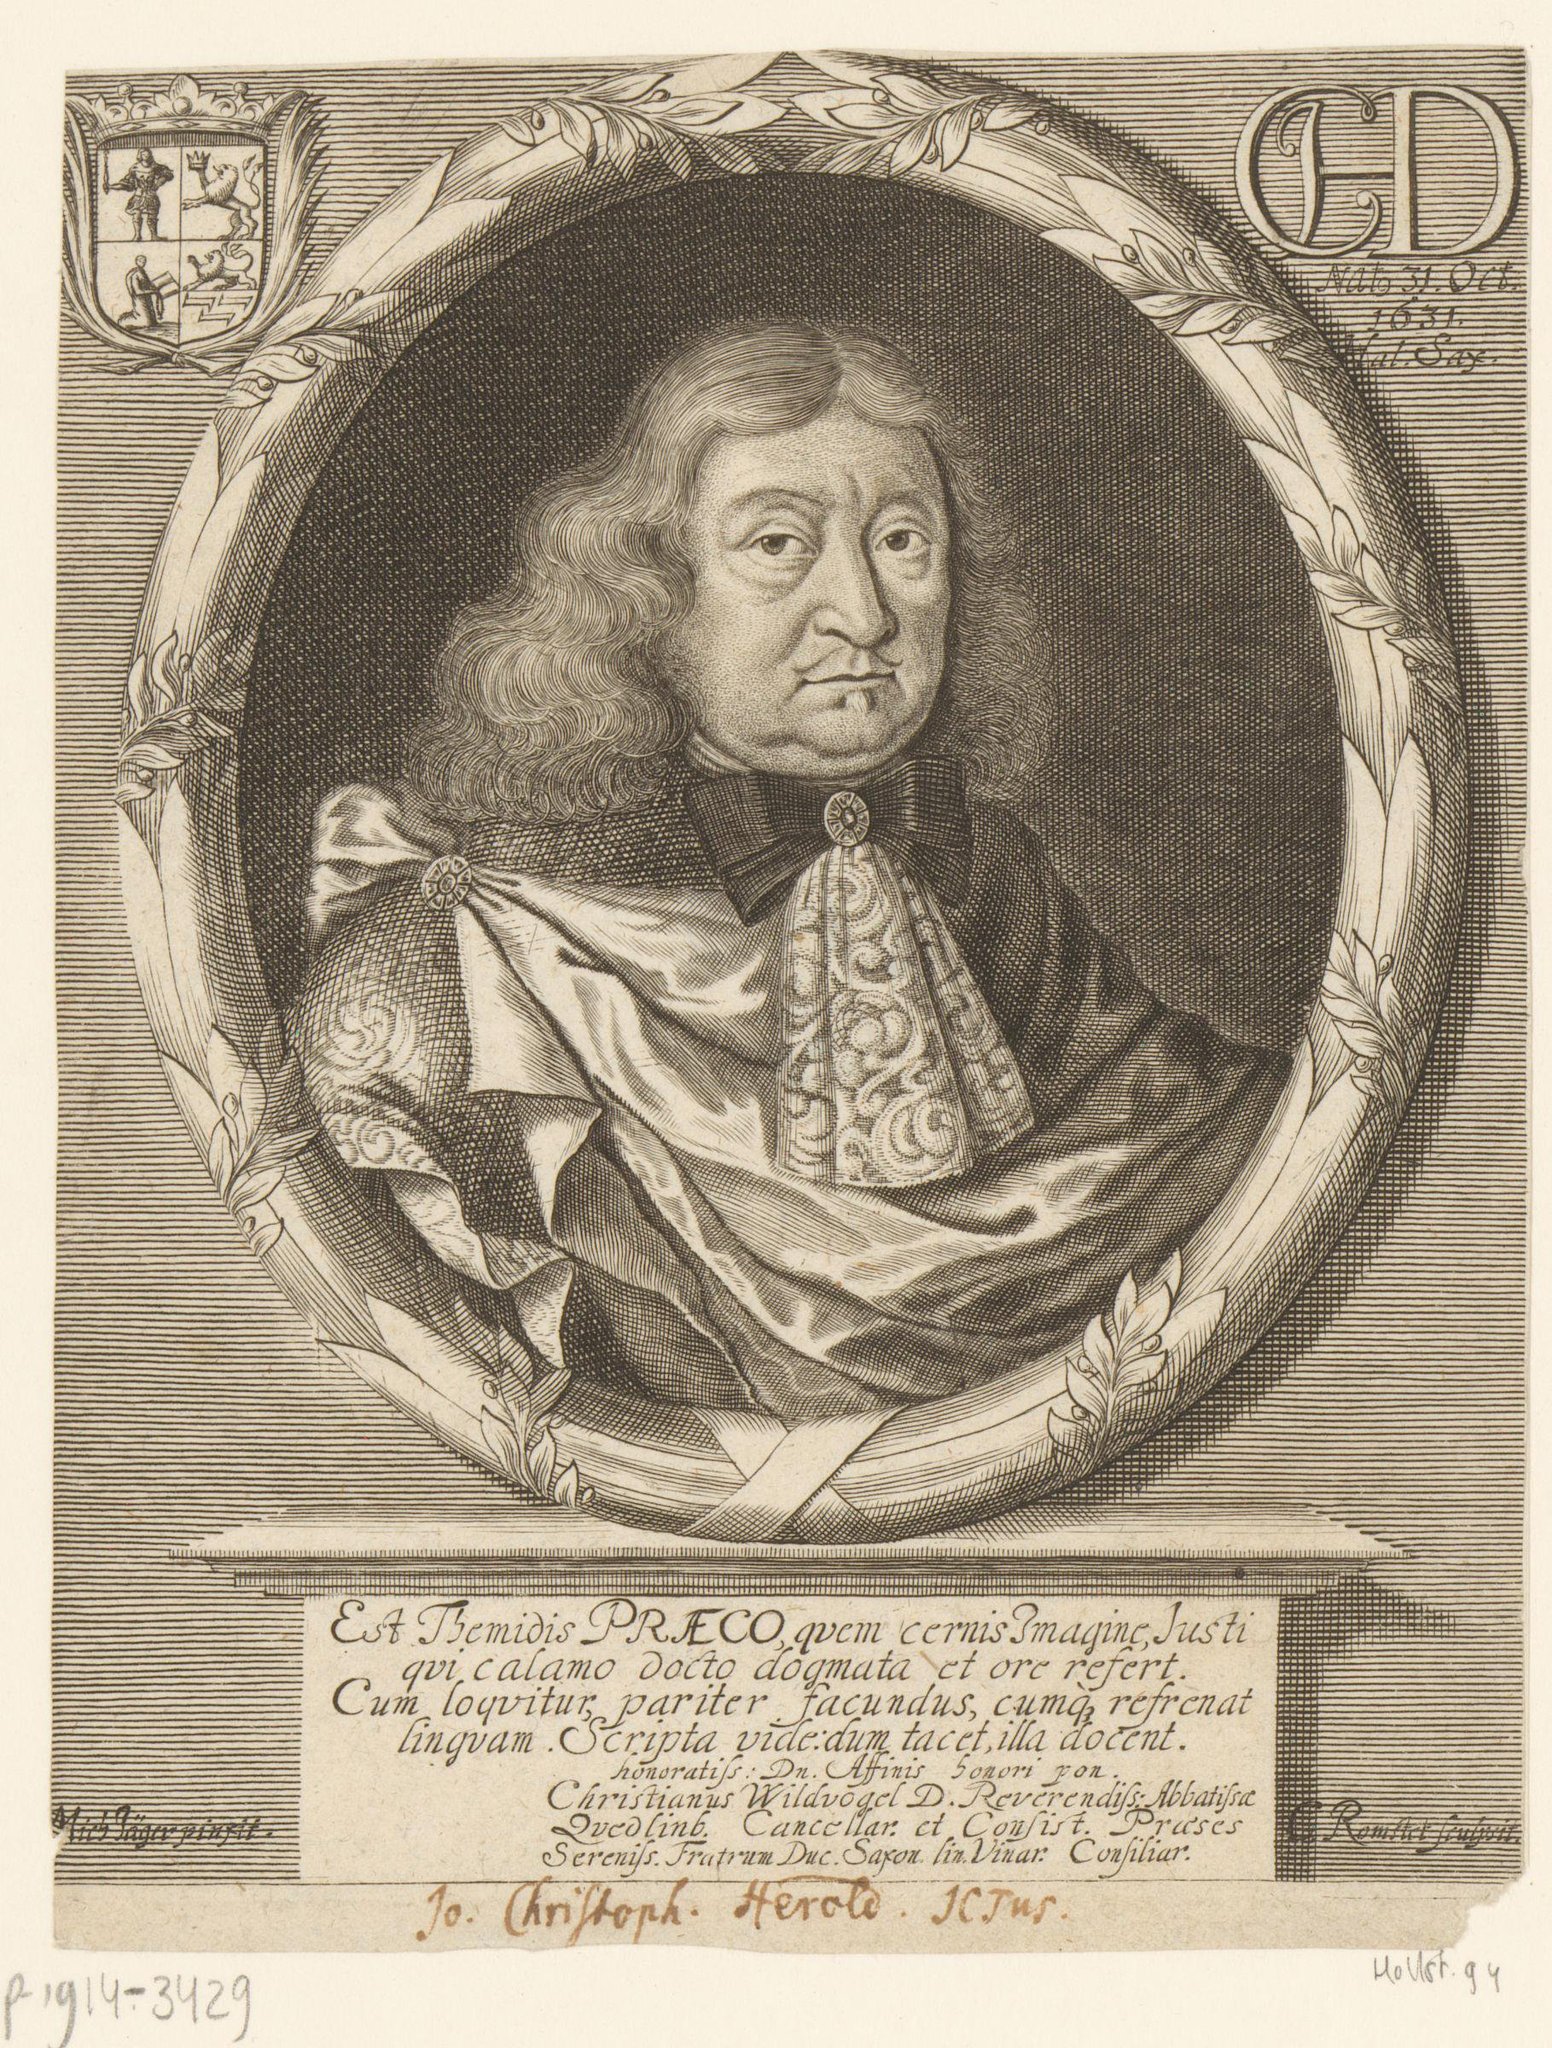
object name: print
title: Portret van Johann Christoph Herold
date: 1665-1721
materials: paper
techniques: engraving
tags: historical persons, armorial bearing, heraldry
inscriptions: collector's mark: Lugt 2228